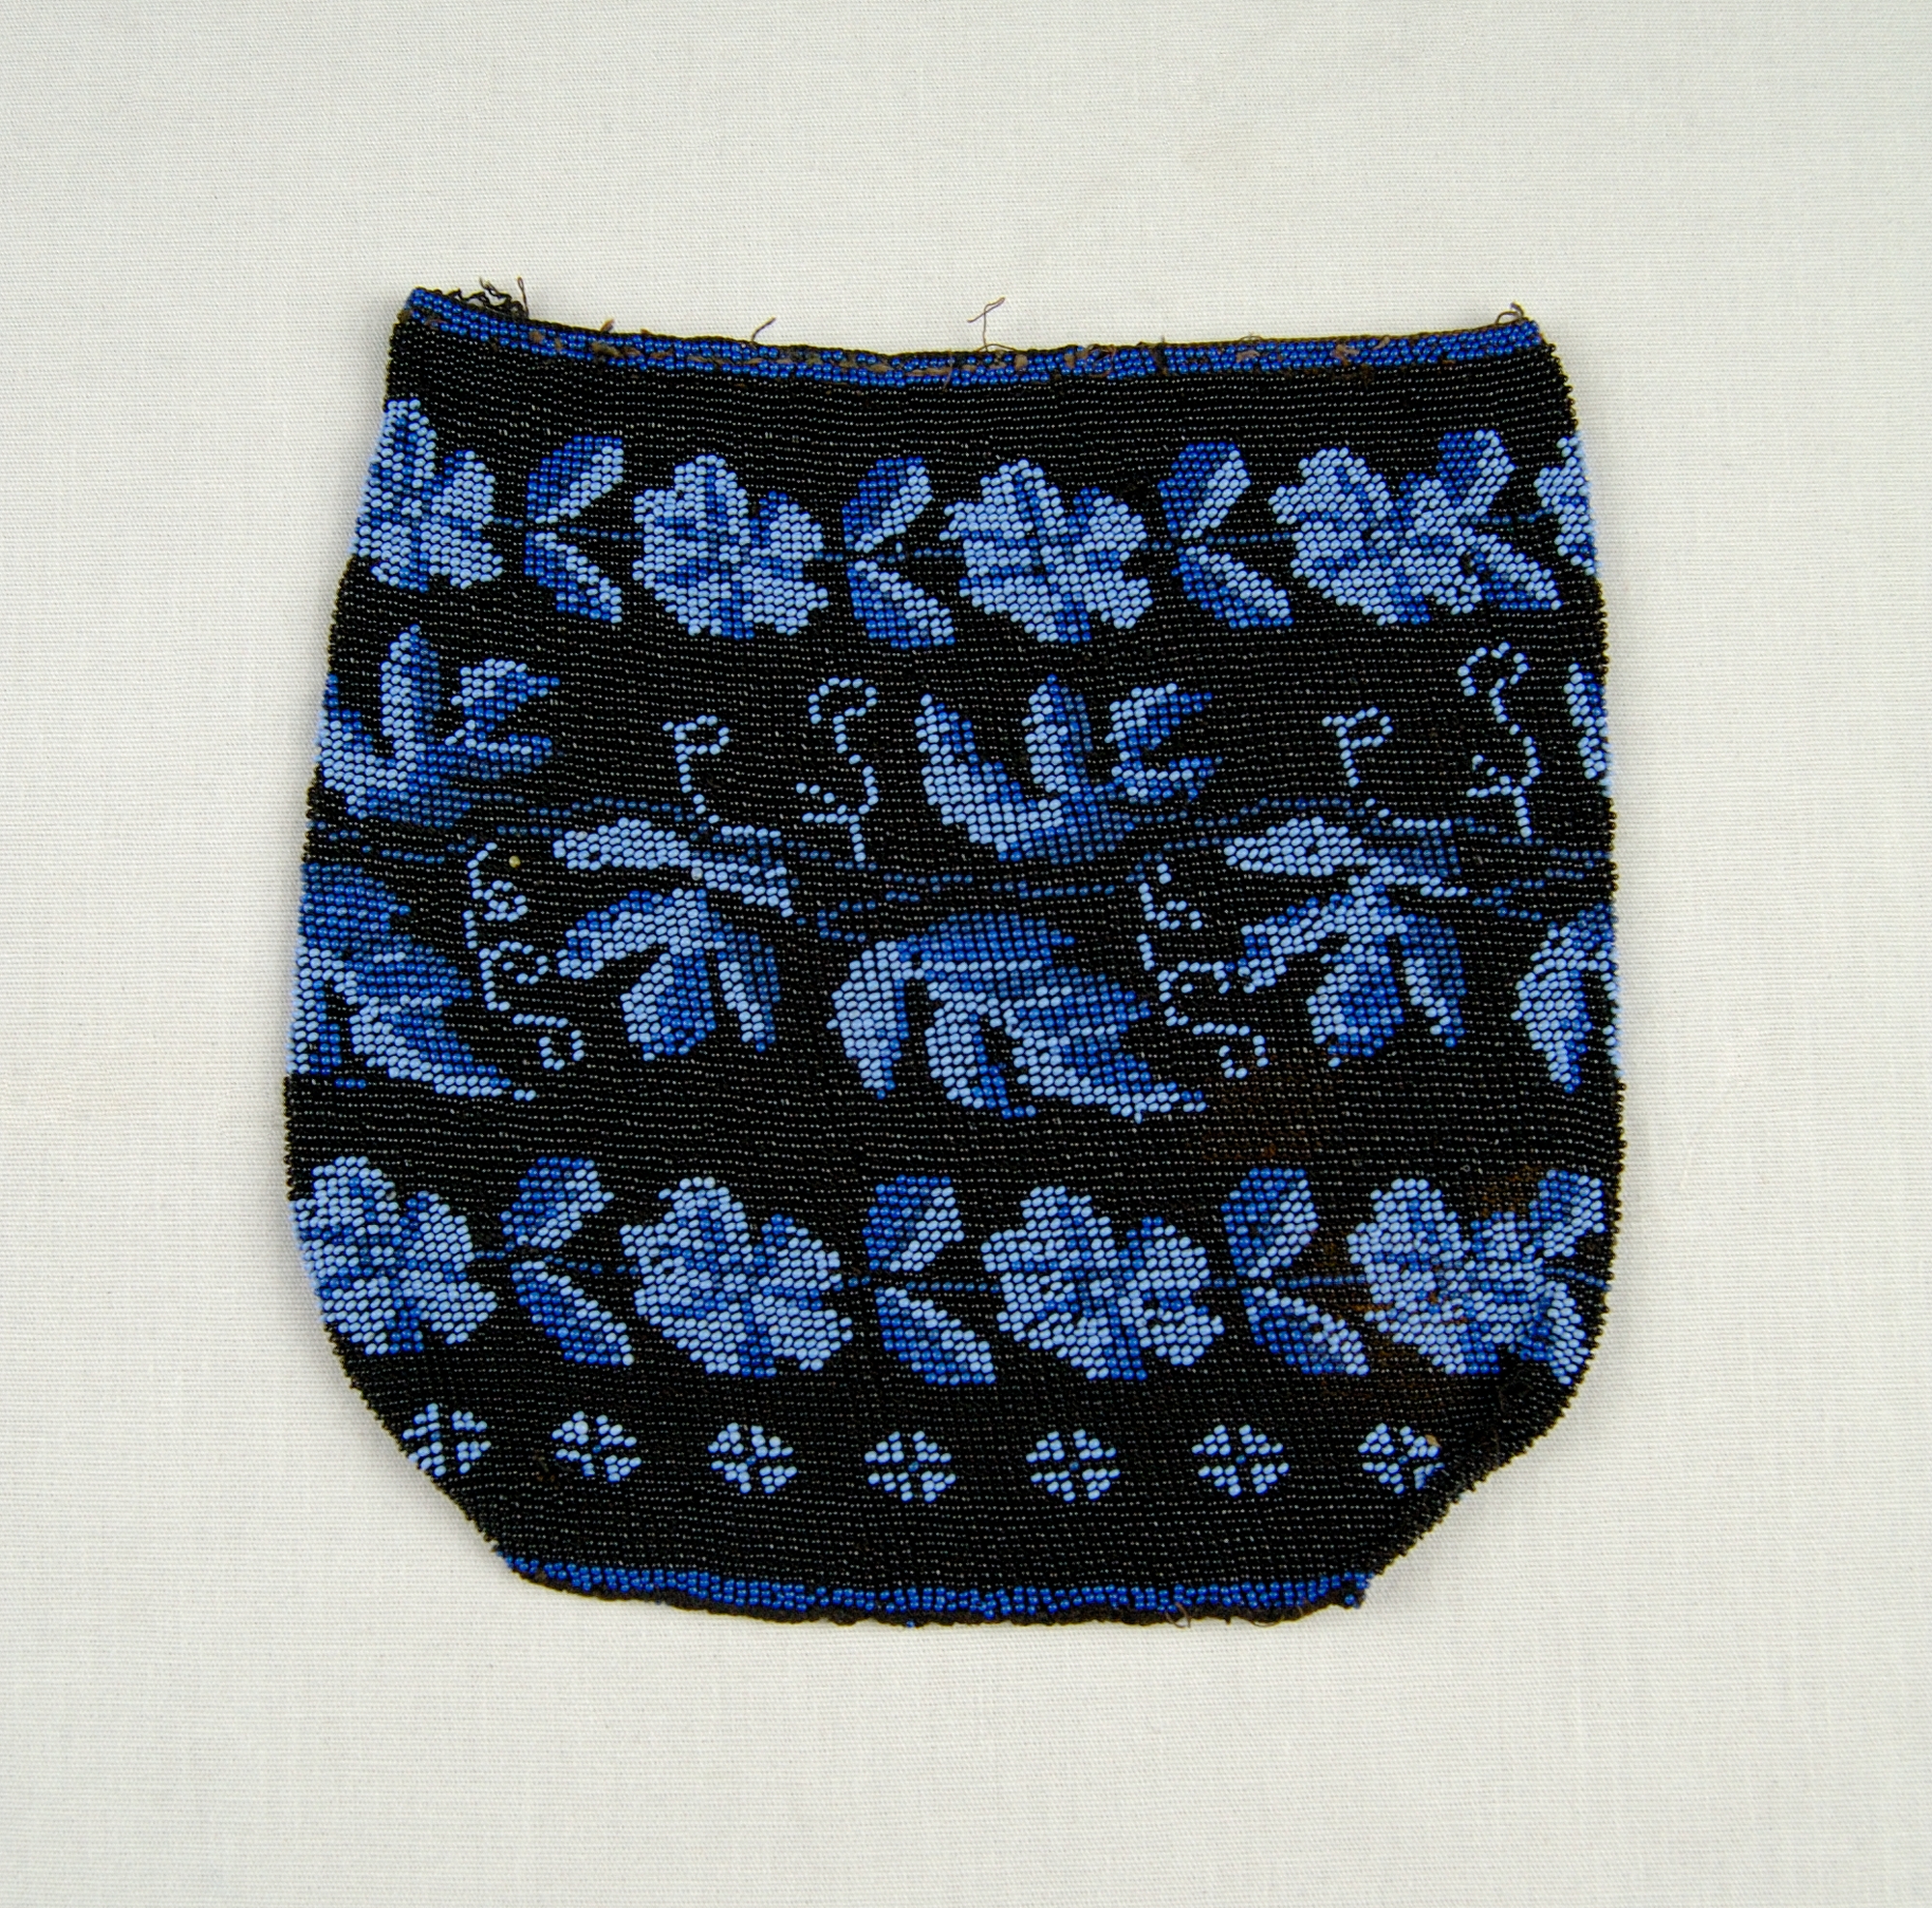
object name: pouch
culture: american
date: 1876-1900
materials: glass, linen